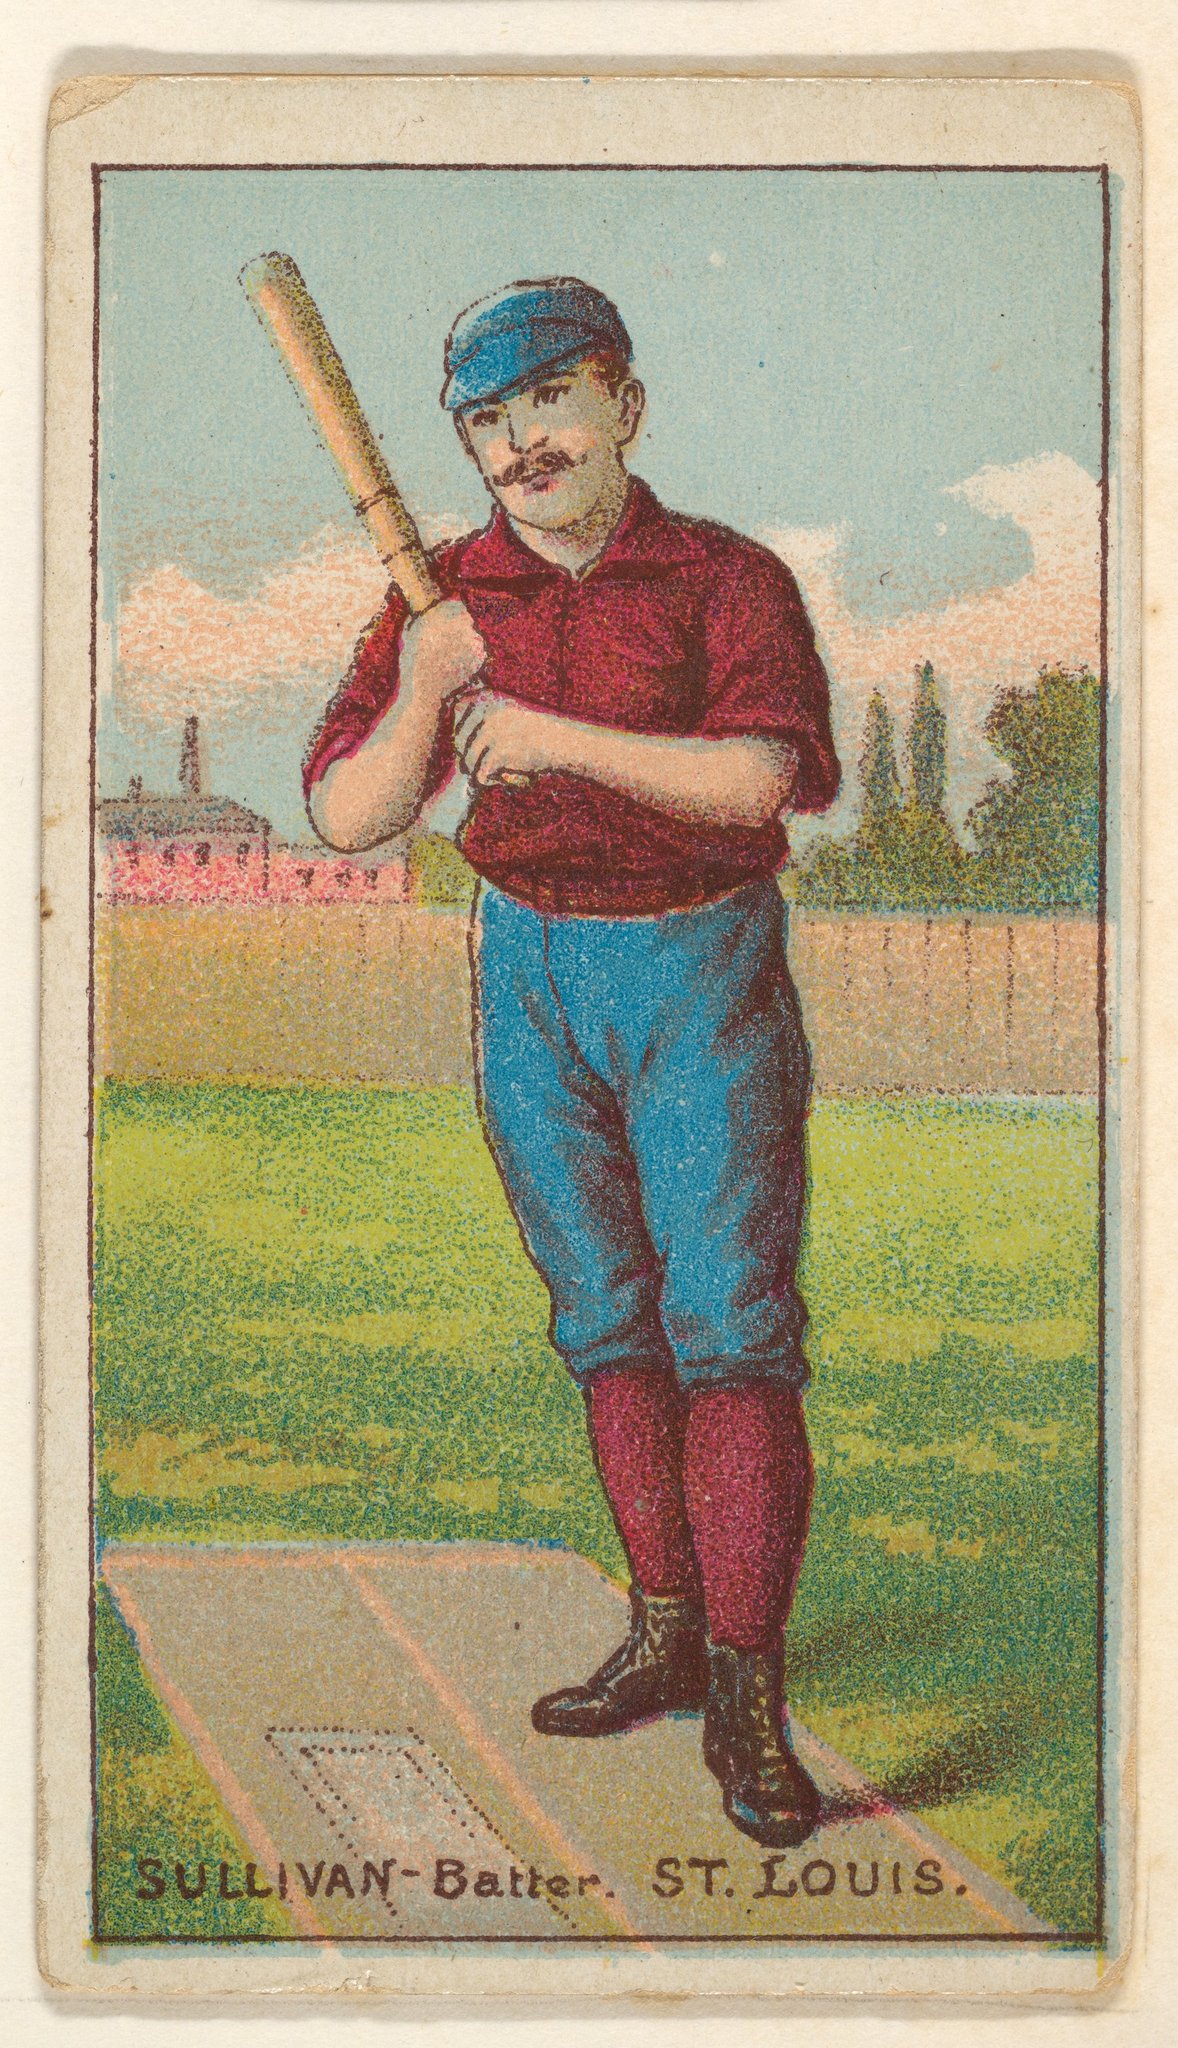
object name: baseball card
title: Sullivan, Batter, St. Louis, from the Gold Coin series (N284) for Gold Coin Chewing Tobacco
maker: d. buchner & co., new york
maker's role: publisher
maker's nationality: american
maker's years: 1850-1900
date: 1887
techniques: color lithograph, drawing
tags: men,baseball,athletes